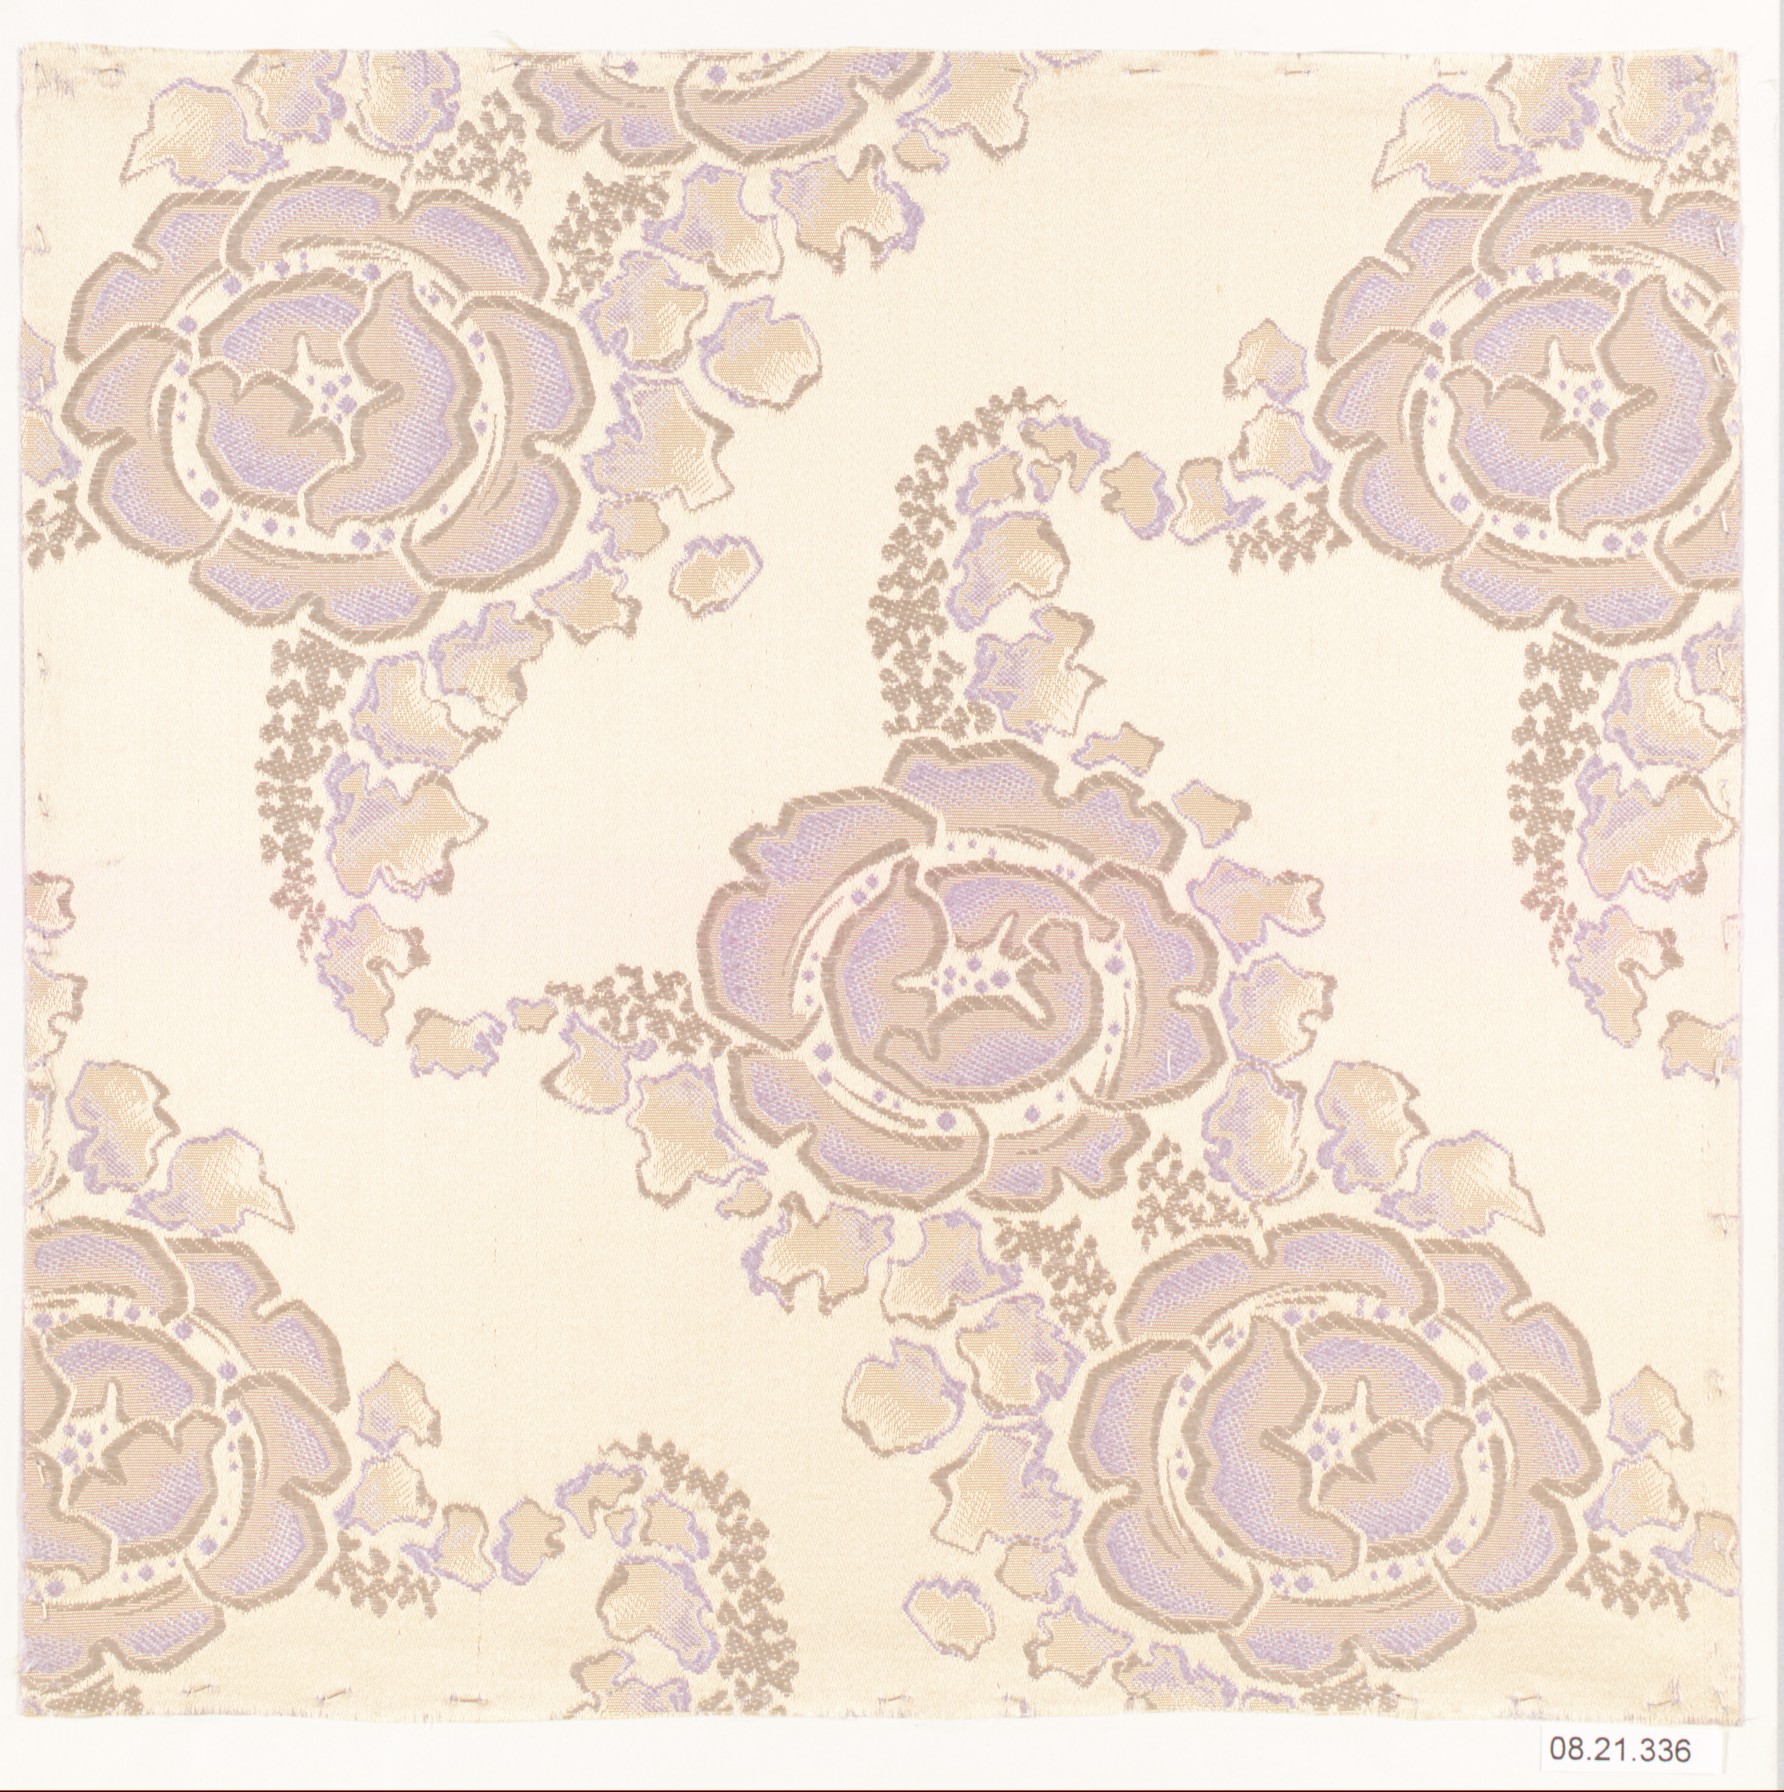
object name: textile sample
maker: Anonymous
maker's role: designer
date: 1900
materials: silk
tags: flowers